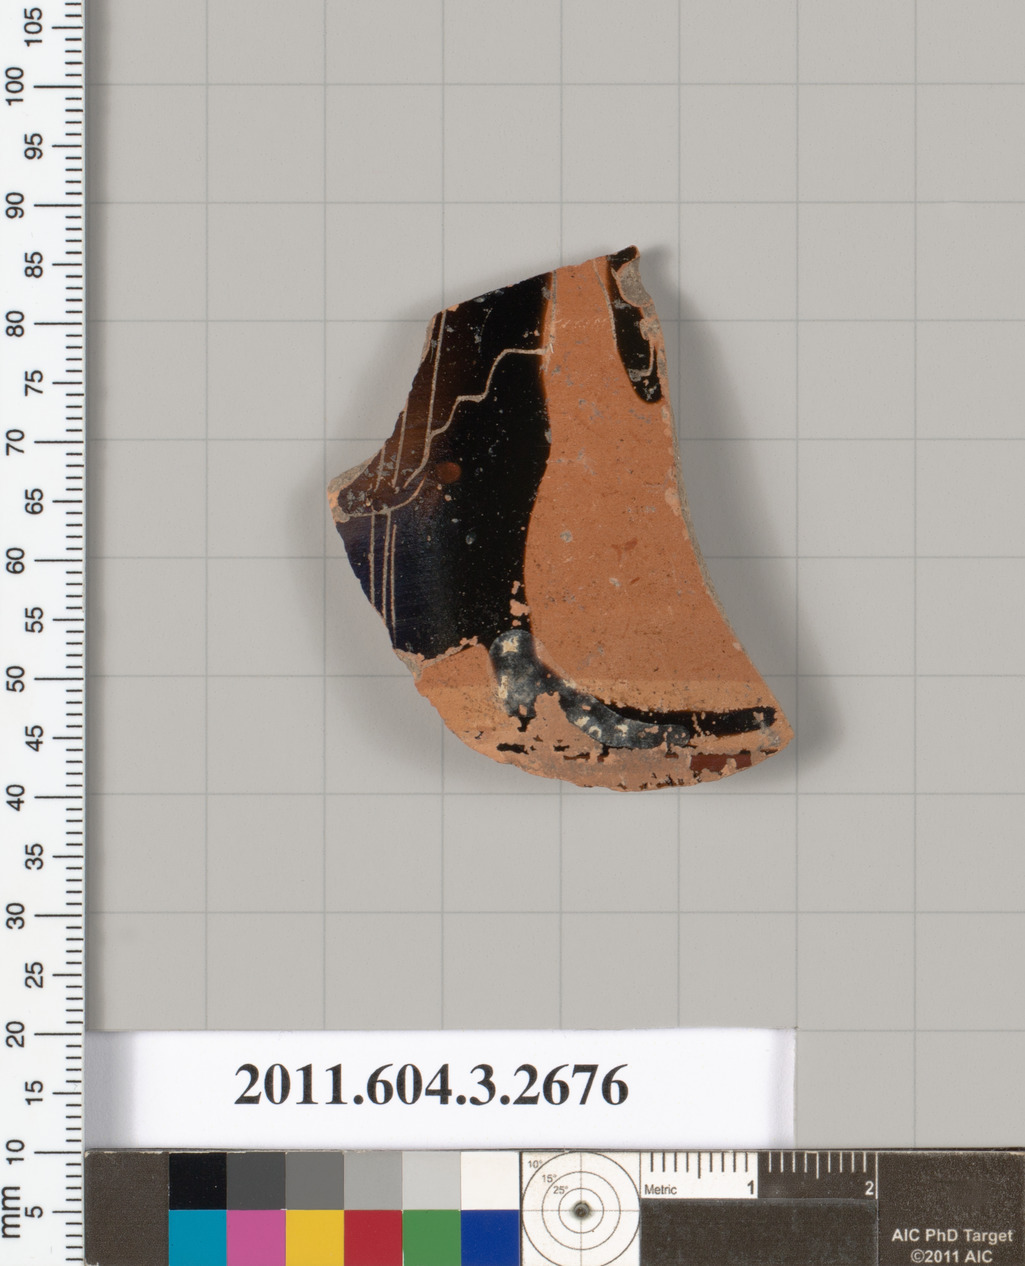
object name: oinochoe fragment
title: Terracotta fragment of an oinochoe (jug)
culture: greek, attic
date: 510-500 BCE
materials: terracotta